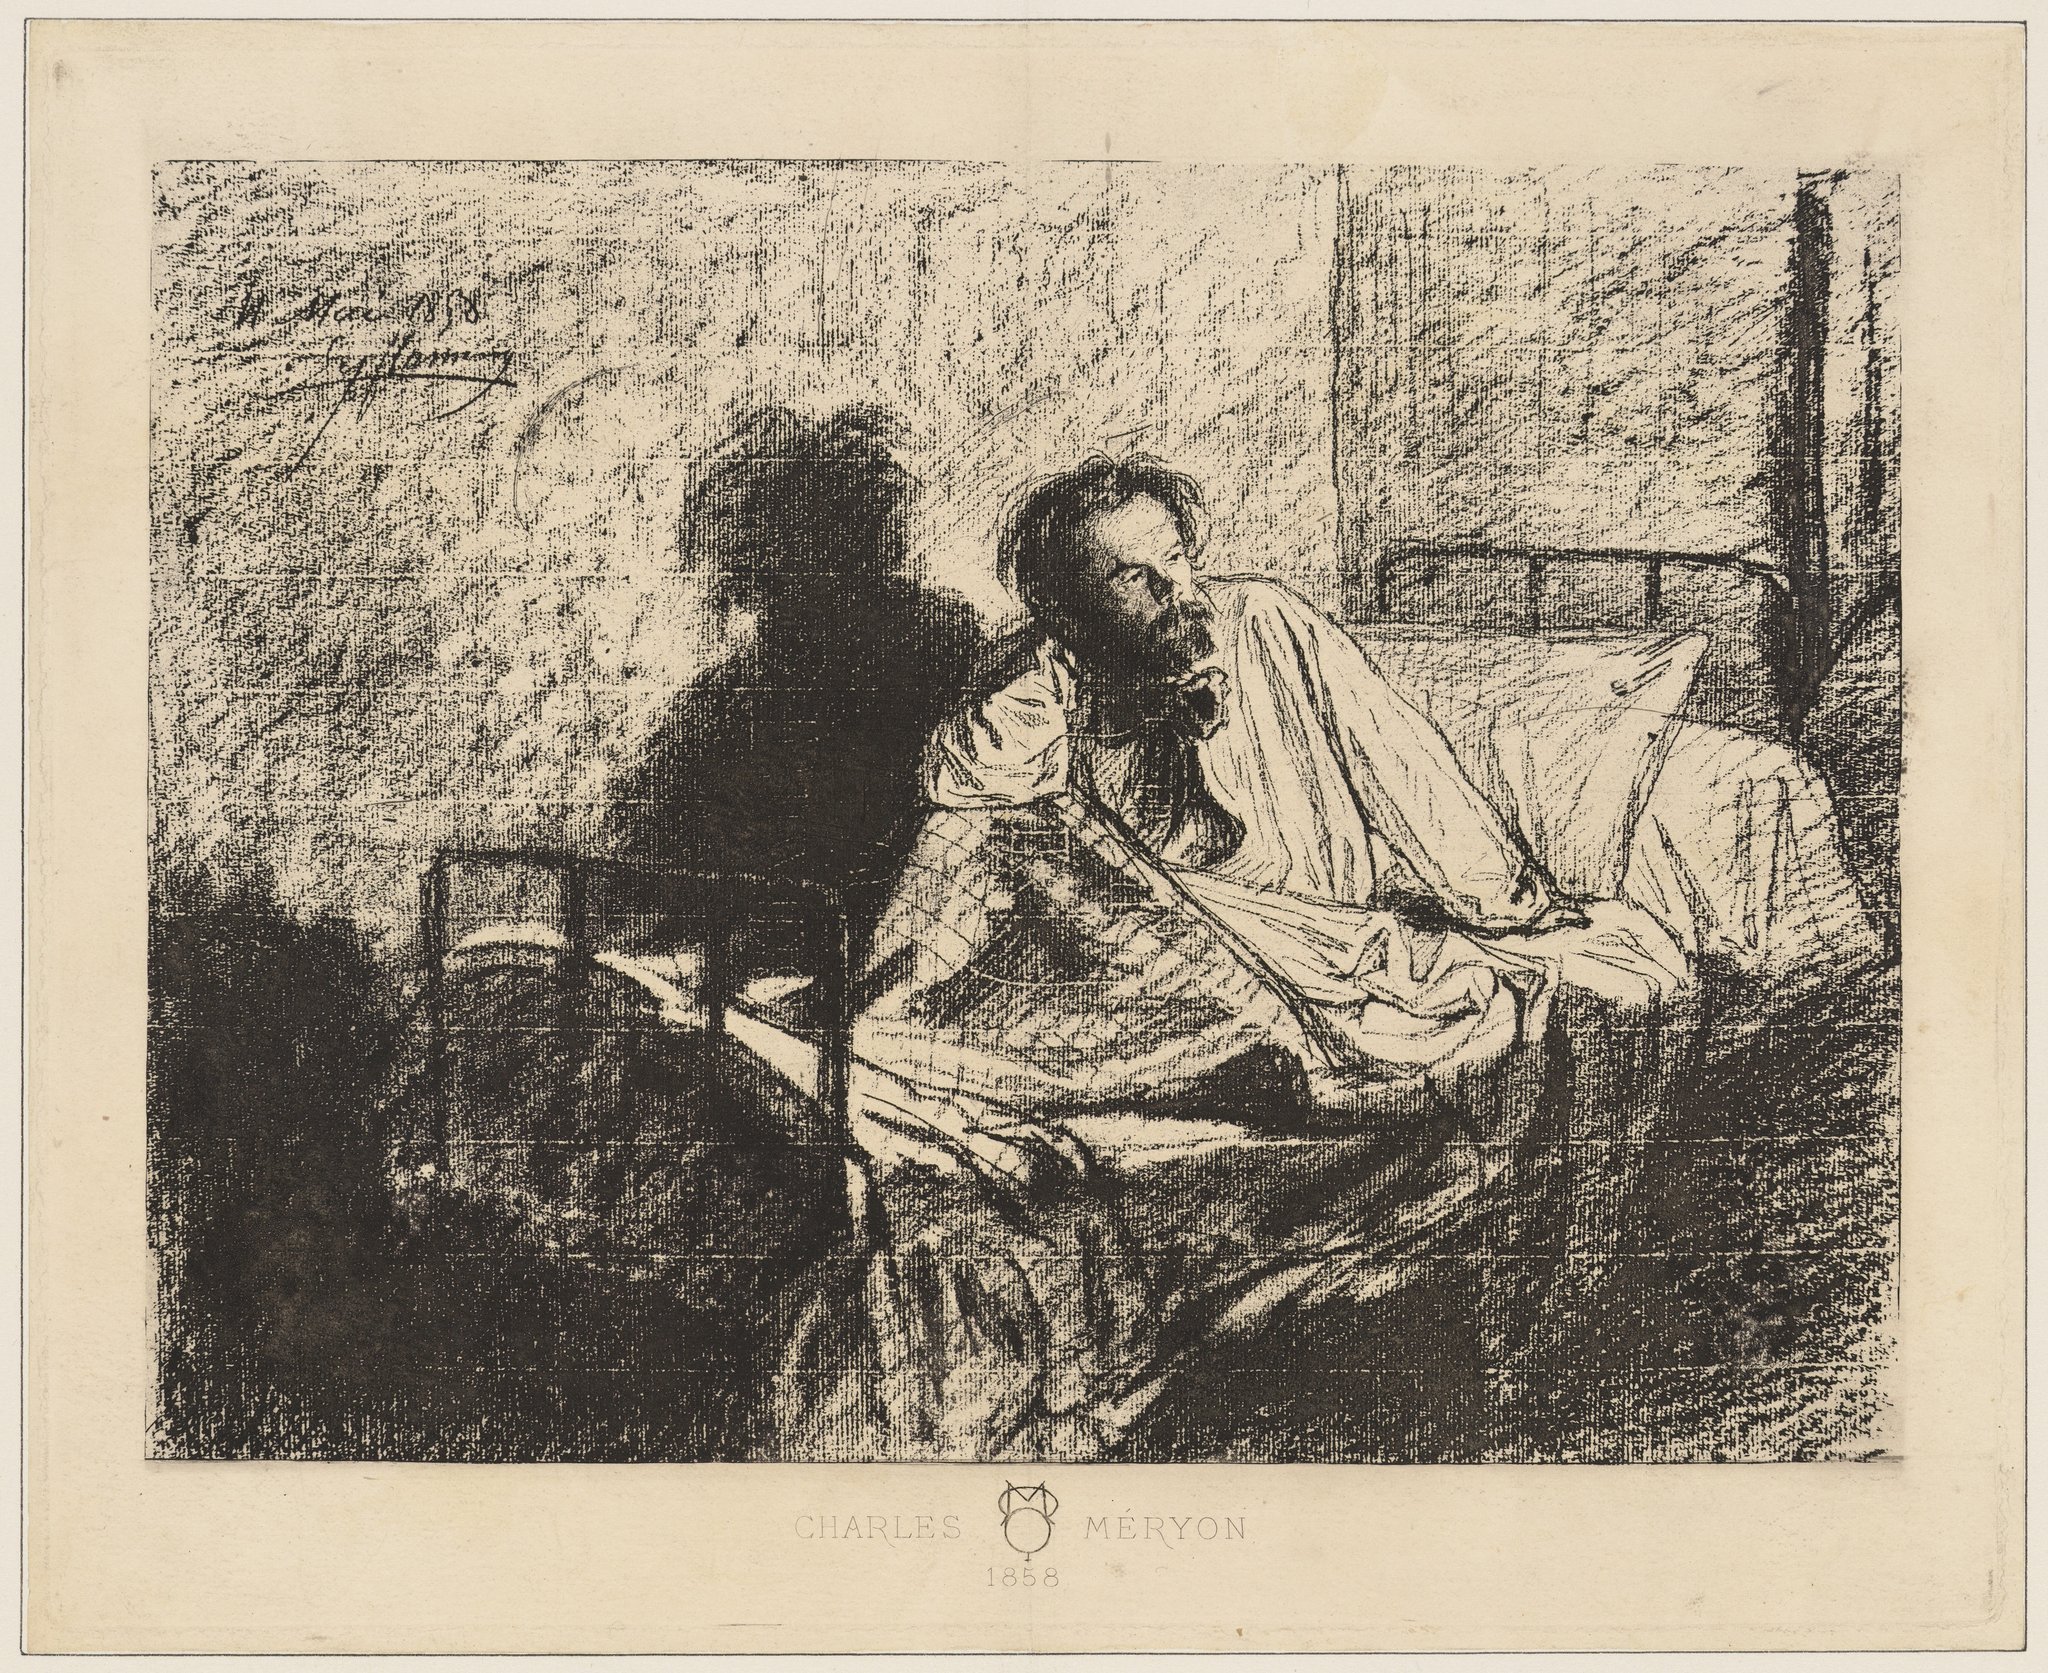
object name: print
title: Portrait of Meryon Sitting up in Bed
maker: léopold flameng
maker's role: engraver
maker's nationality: french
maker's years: 1831-1911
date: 1858